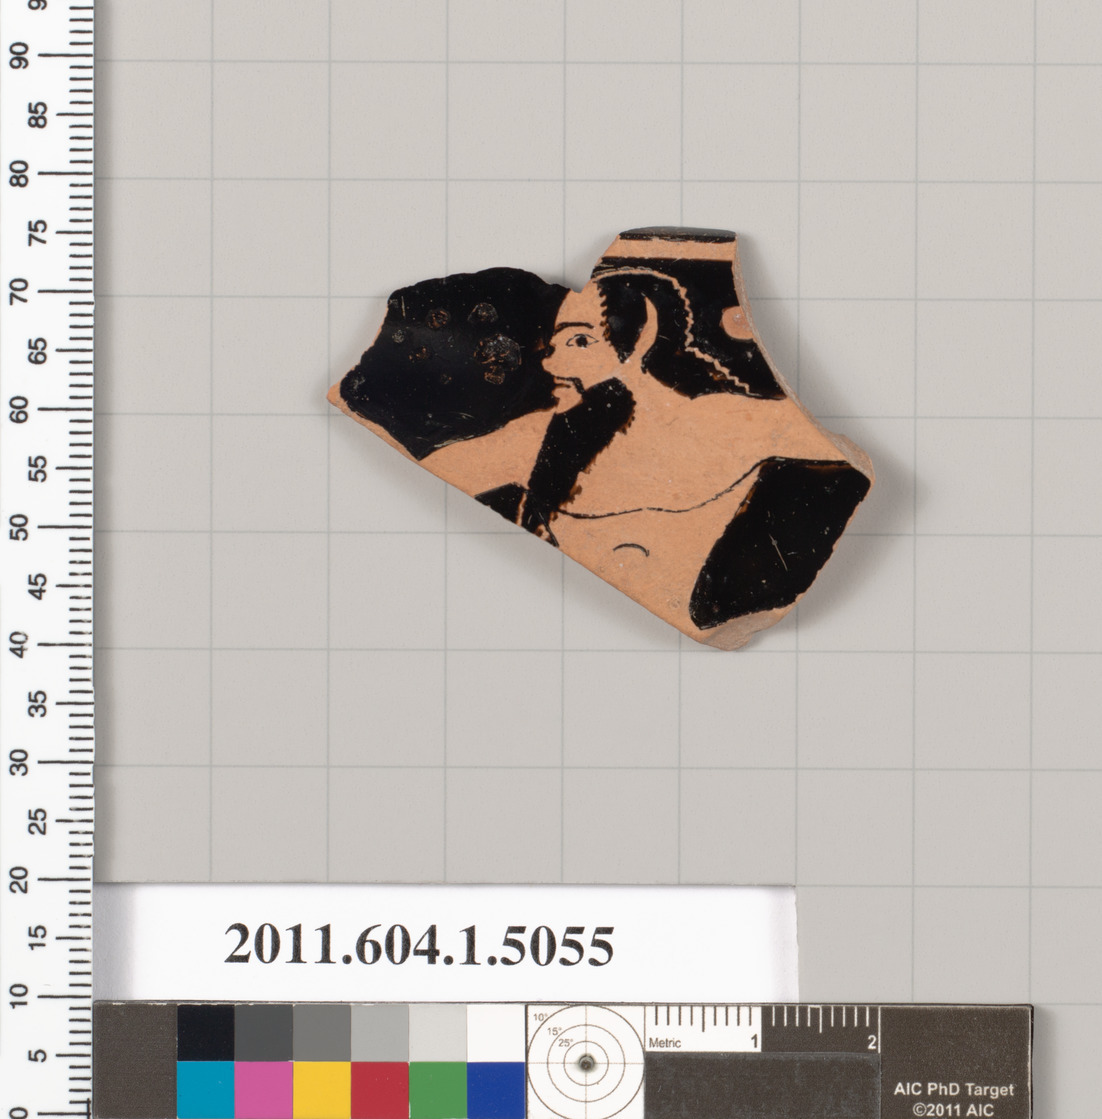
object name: kylix fragment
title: Terracotta fragment of a kylix (drinking cup)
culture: greek, attic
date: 520-500 BCE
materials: terracotta